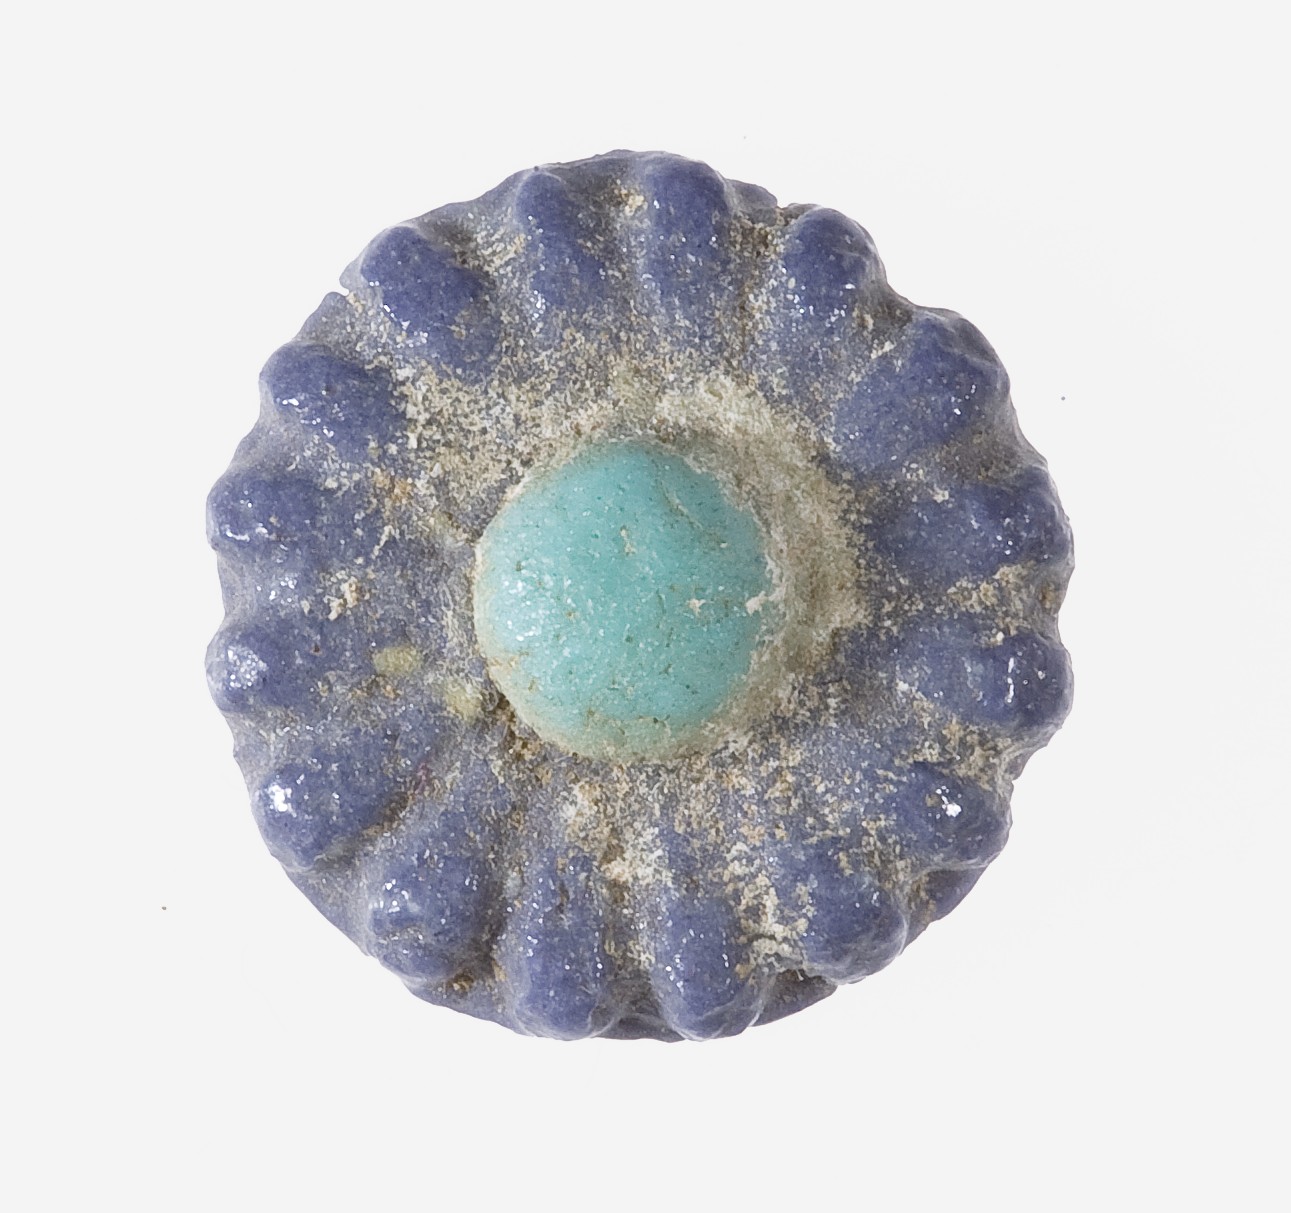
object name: pendant, daisy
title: Daisy Pendant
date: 1390-1352 BCE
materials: faience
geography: egypt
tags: flowers